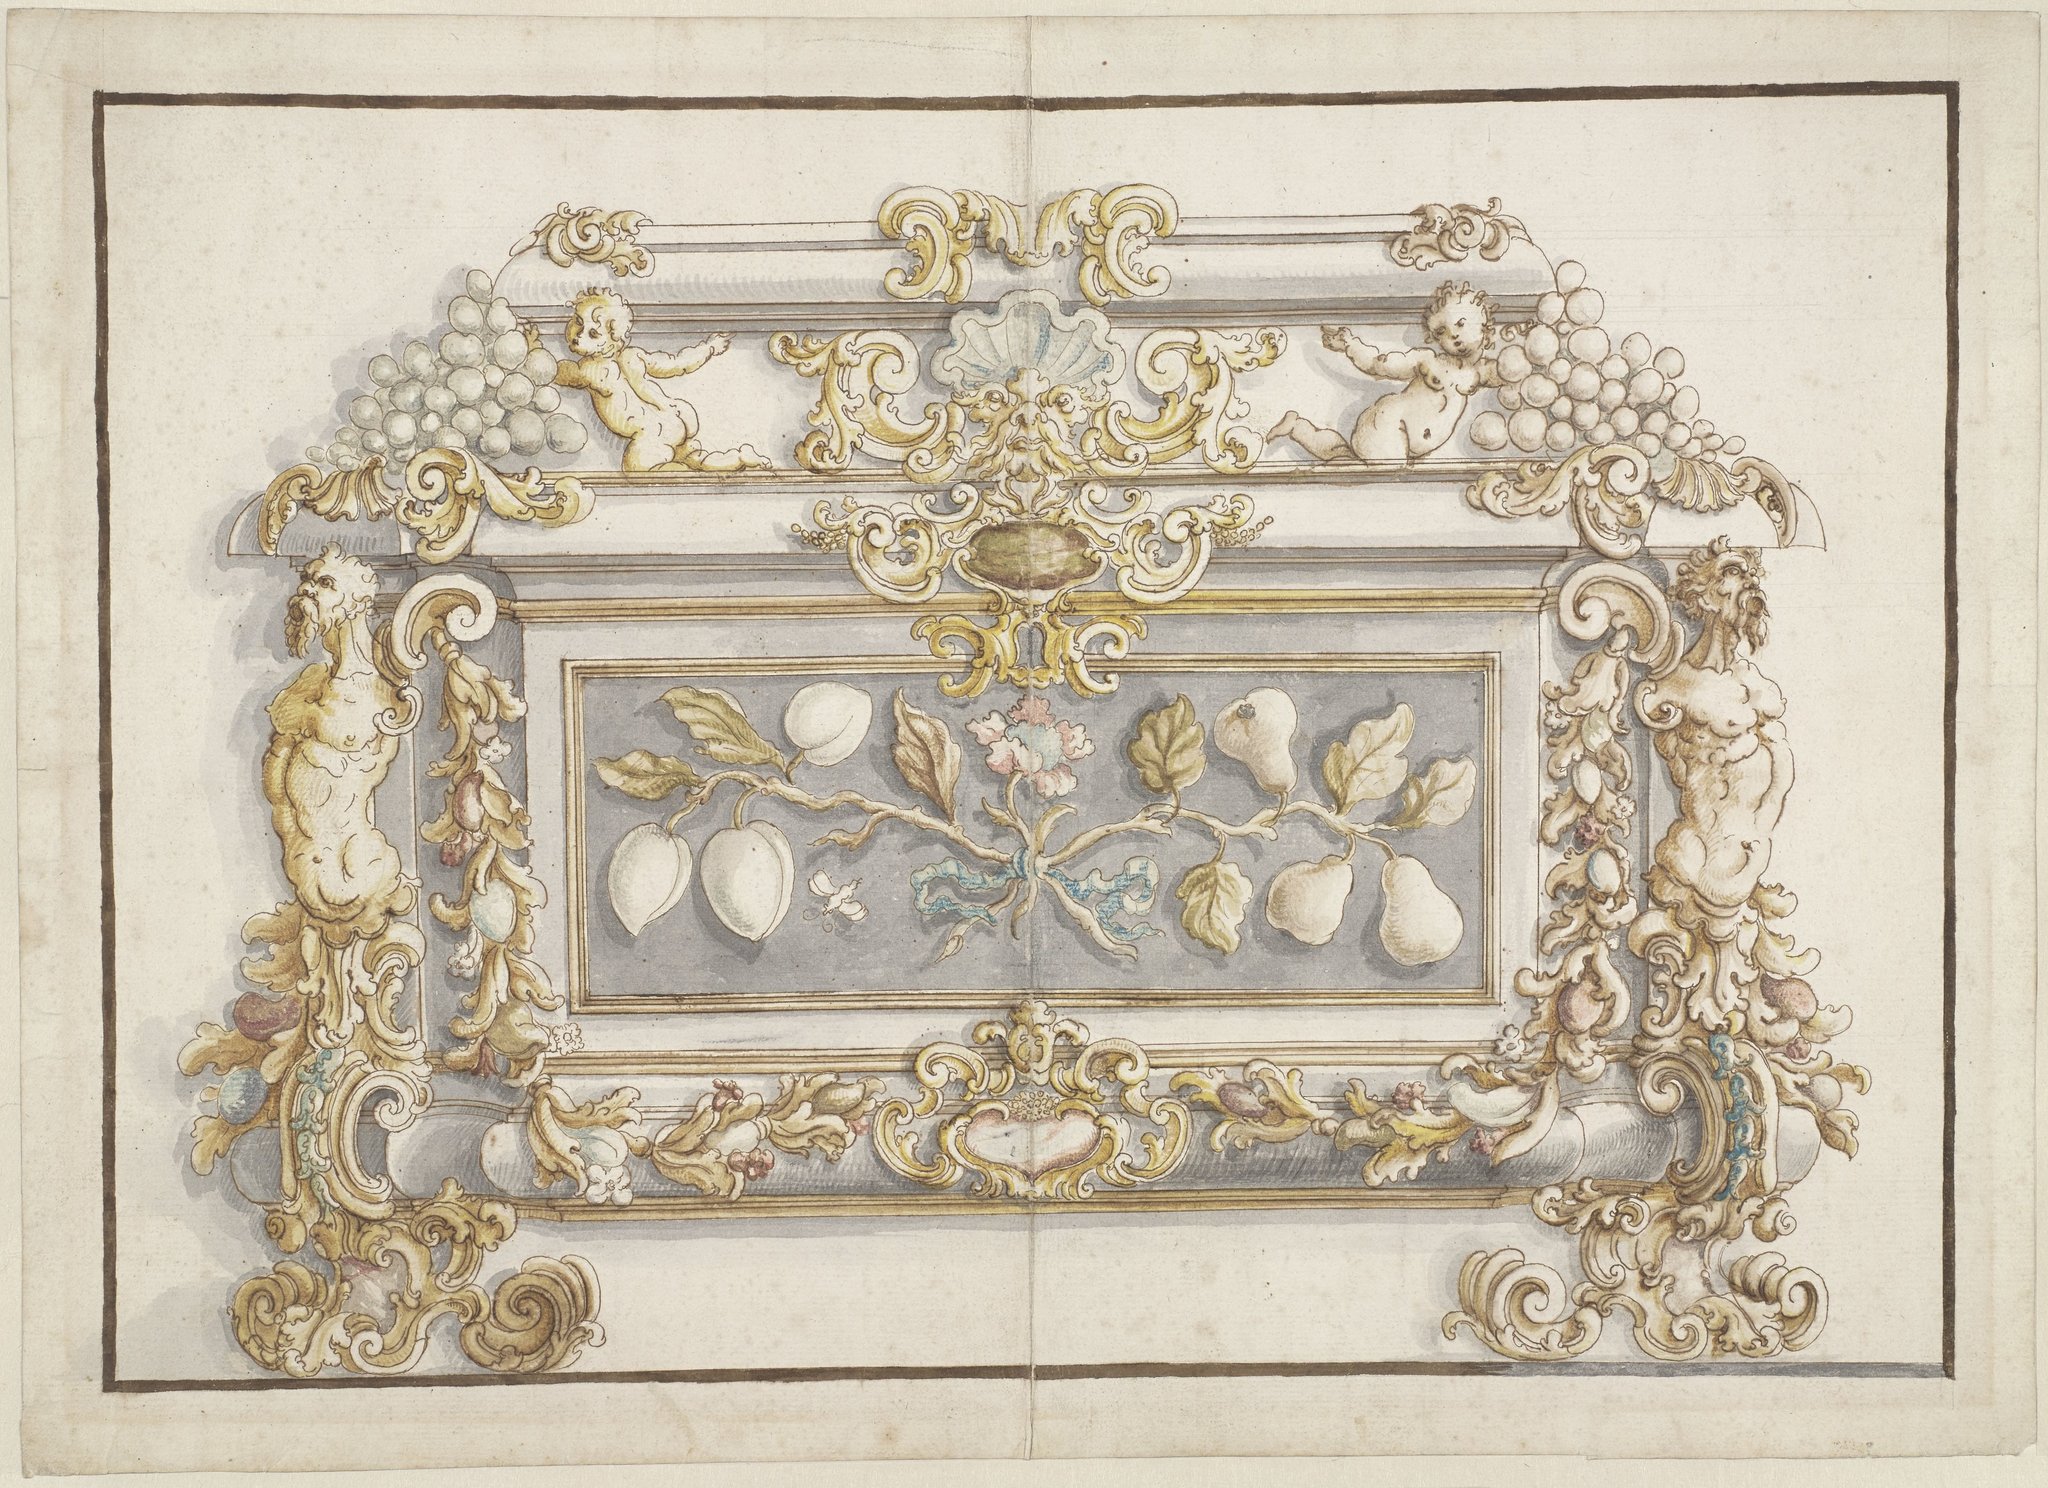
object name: design drawing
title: Ontwerp voor een met pietre dure panelen ingelegd met verguld brons gemonteerd kistje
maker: giovanni battista foggini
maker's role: draughtsman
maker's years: 1652-1725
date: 1710-1725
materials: ink, paper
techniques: brush, pen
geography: florence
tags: decorative furniture, container of precious metal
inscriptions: annotation, annotation: ‘Collection: / Andrew Fountaine Esq / Narford Hall, Norfolk’